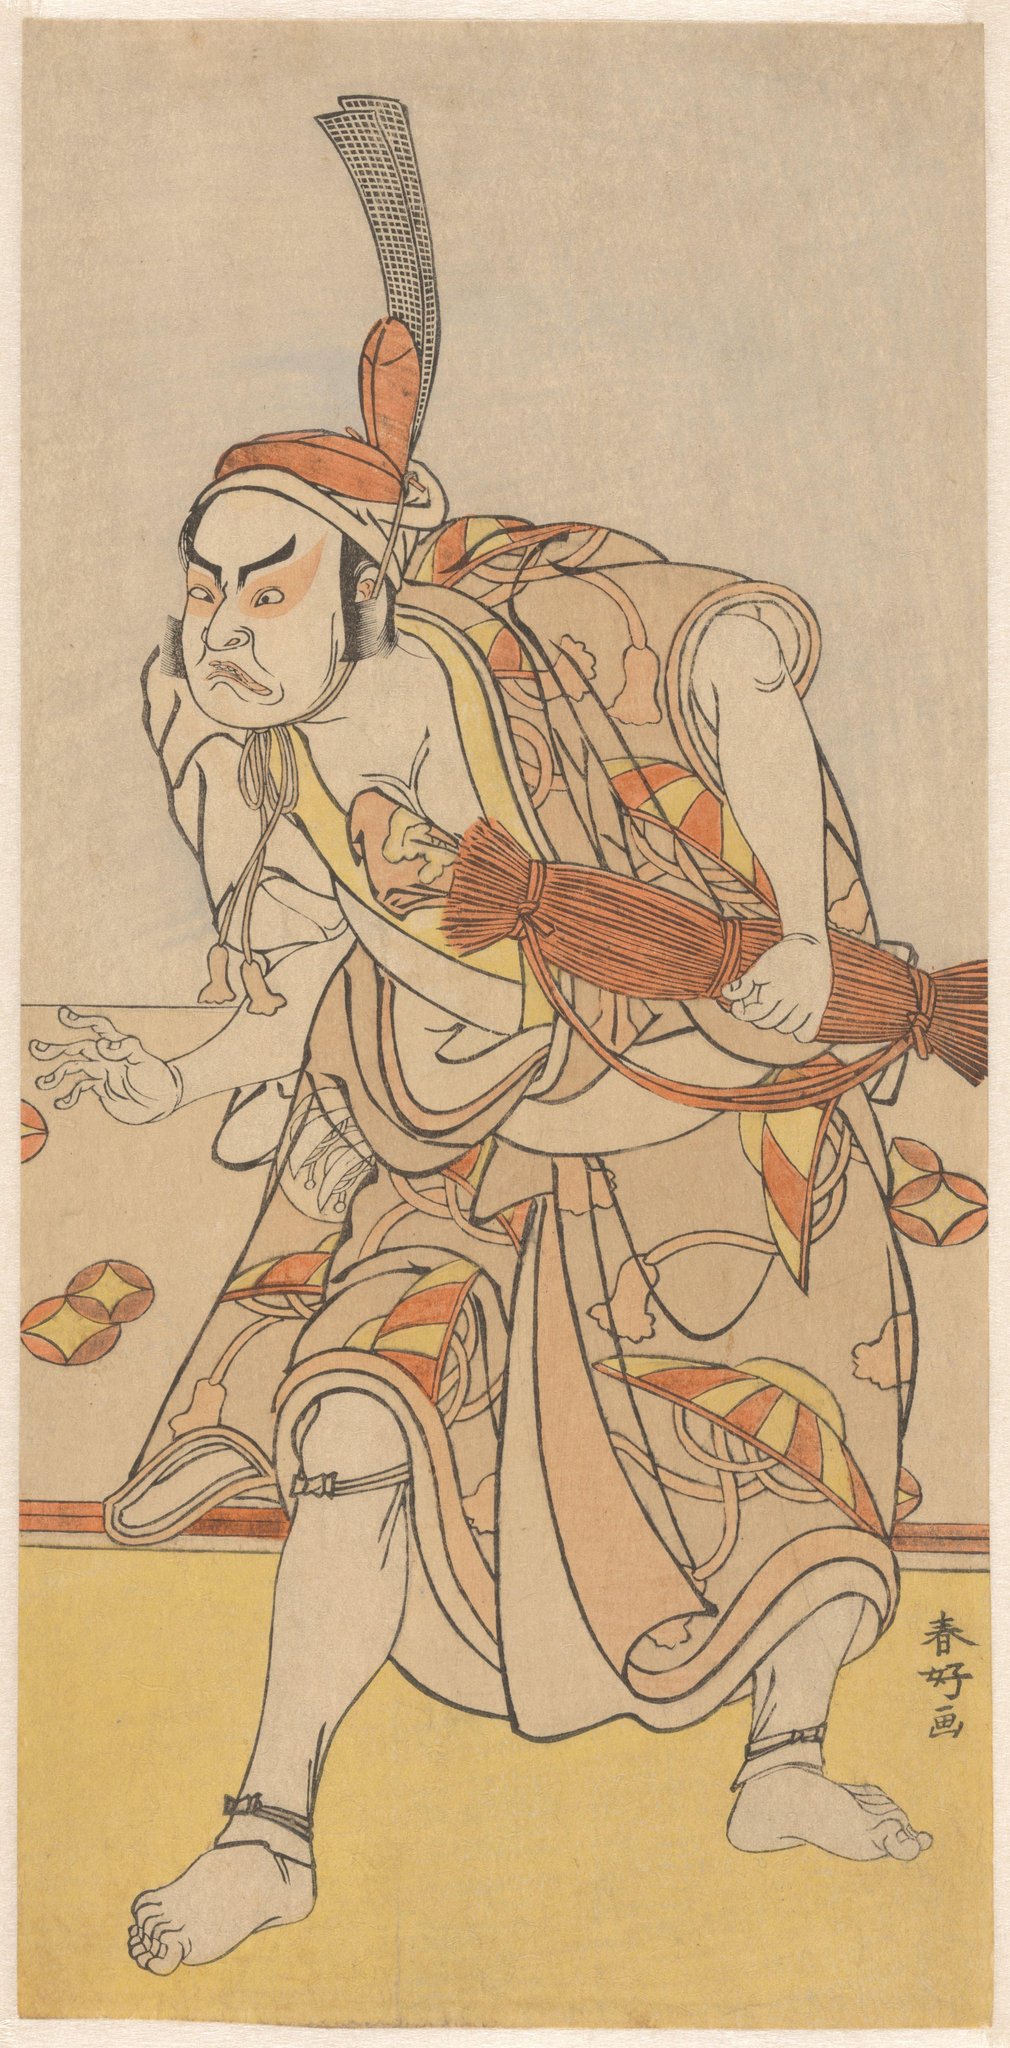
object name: print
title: Actor as courtier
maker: katsukawa shunko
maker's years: 1743-1812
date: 1770-1790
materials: paper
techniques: woodcut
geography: japan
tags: carrying something, actor (on the stage)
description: Kabuki acteur Nakajima Miho-emon II vermomd als hoveling. Onder zijn arm draagt hij een strooien mat, waarin hij waarschijnlijk een zwaard verbergt. Het patroon van hoeden op zijn kleding verwijst naar de de Zeven Schatten en zou hem onzichtbaar maken. Op zijn hoofd de typerende hofhoed. De rode schminkt rond zijn ogen benadrukt kracht en doorzettingsveermogen.